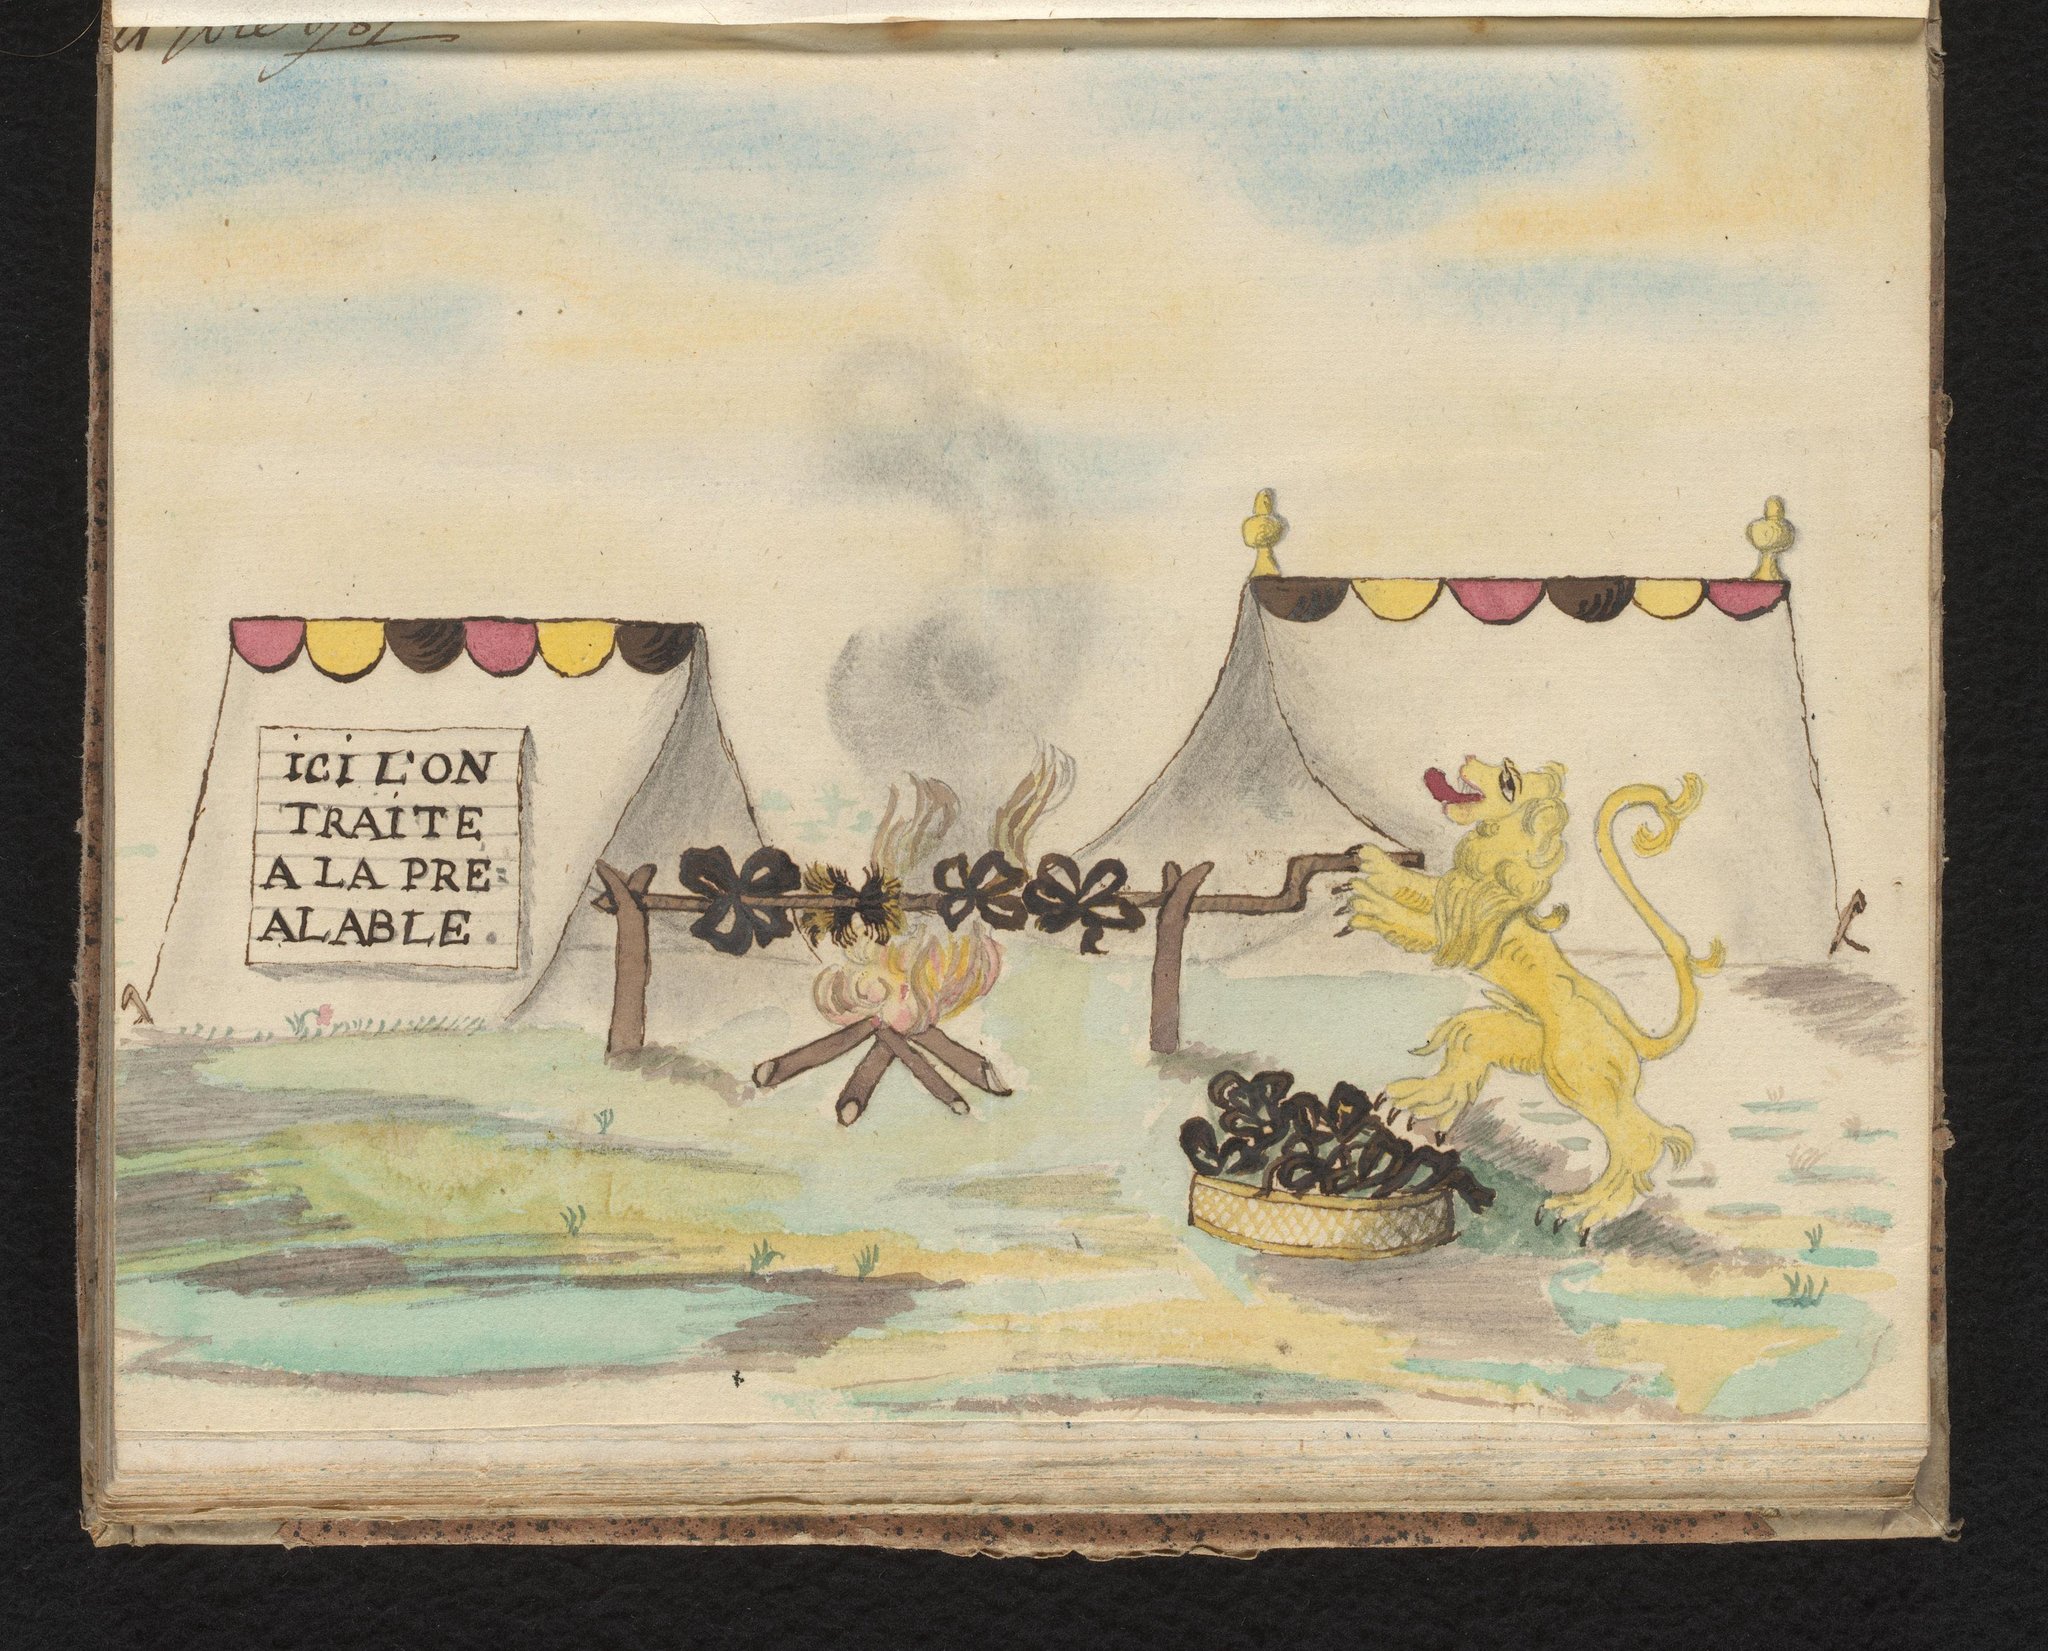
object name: drawing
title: Hier onderhandelt men over de voorwaarden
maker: Anonymous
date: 1787-1791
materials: paper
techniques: drawing, writing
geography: southern netherlands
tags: spit ~ cooking - cc - in the open air, brabant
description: De Brabantse leeuw roostert kokardes aan een spit boven een vuurtje. Links en rechts twee tenten. Onderdeel van de gebundelde verzameling prenten betrekking hebbend op de gebeurtenissen van de Brabantse Omwenteling en de periode 1787-1790.